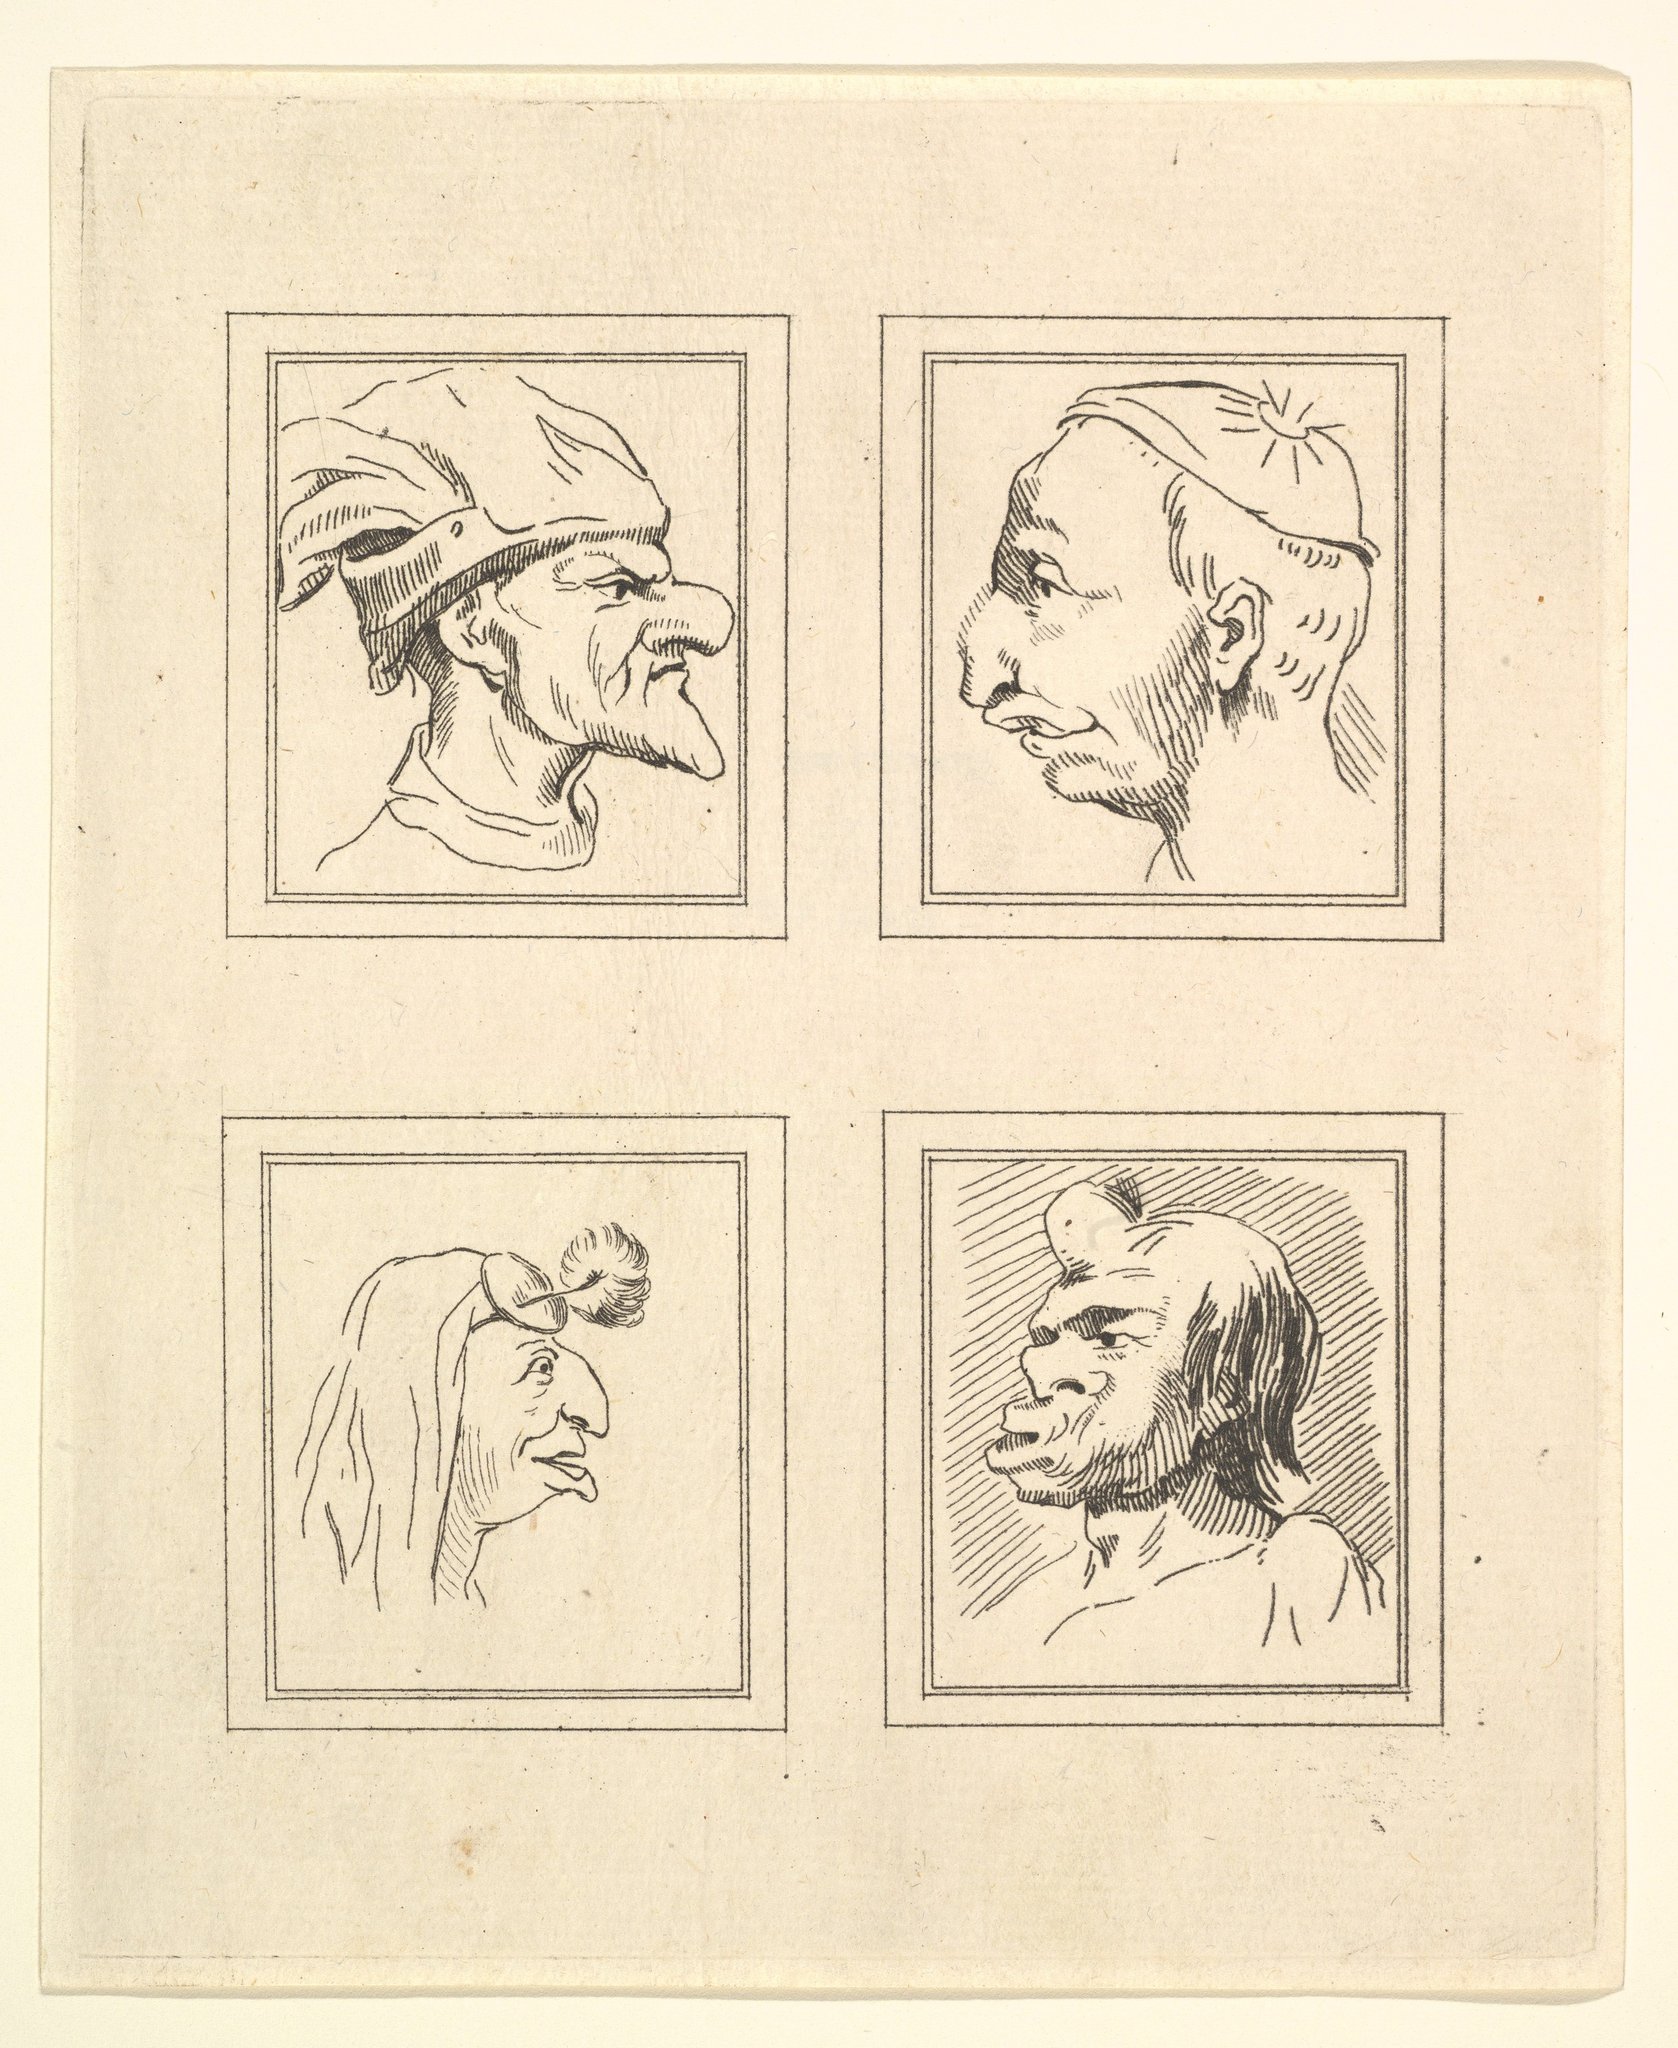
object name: print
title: Four Heads (from Characaturas by Leonardo da Vinci, from Drawings by Wincelslaus Hollar, out of the Portland Museum)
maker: wenceslaus hollar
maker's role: artist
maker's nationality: bohemian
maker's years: 1607-1677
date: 1786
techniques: etching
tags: heads,men,profiles